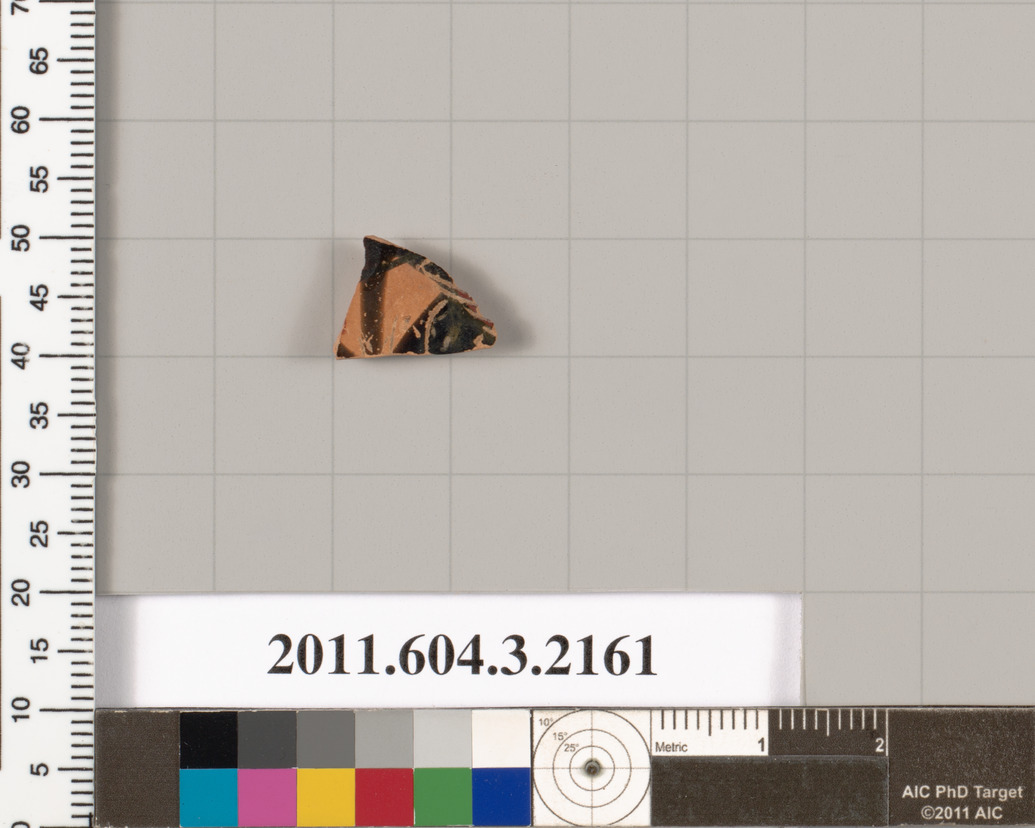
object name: kylix fragment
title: Terracotta fragment of a kylix (drinking cup)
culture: greek, attic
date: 534-468 BCE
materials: terracotta